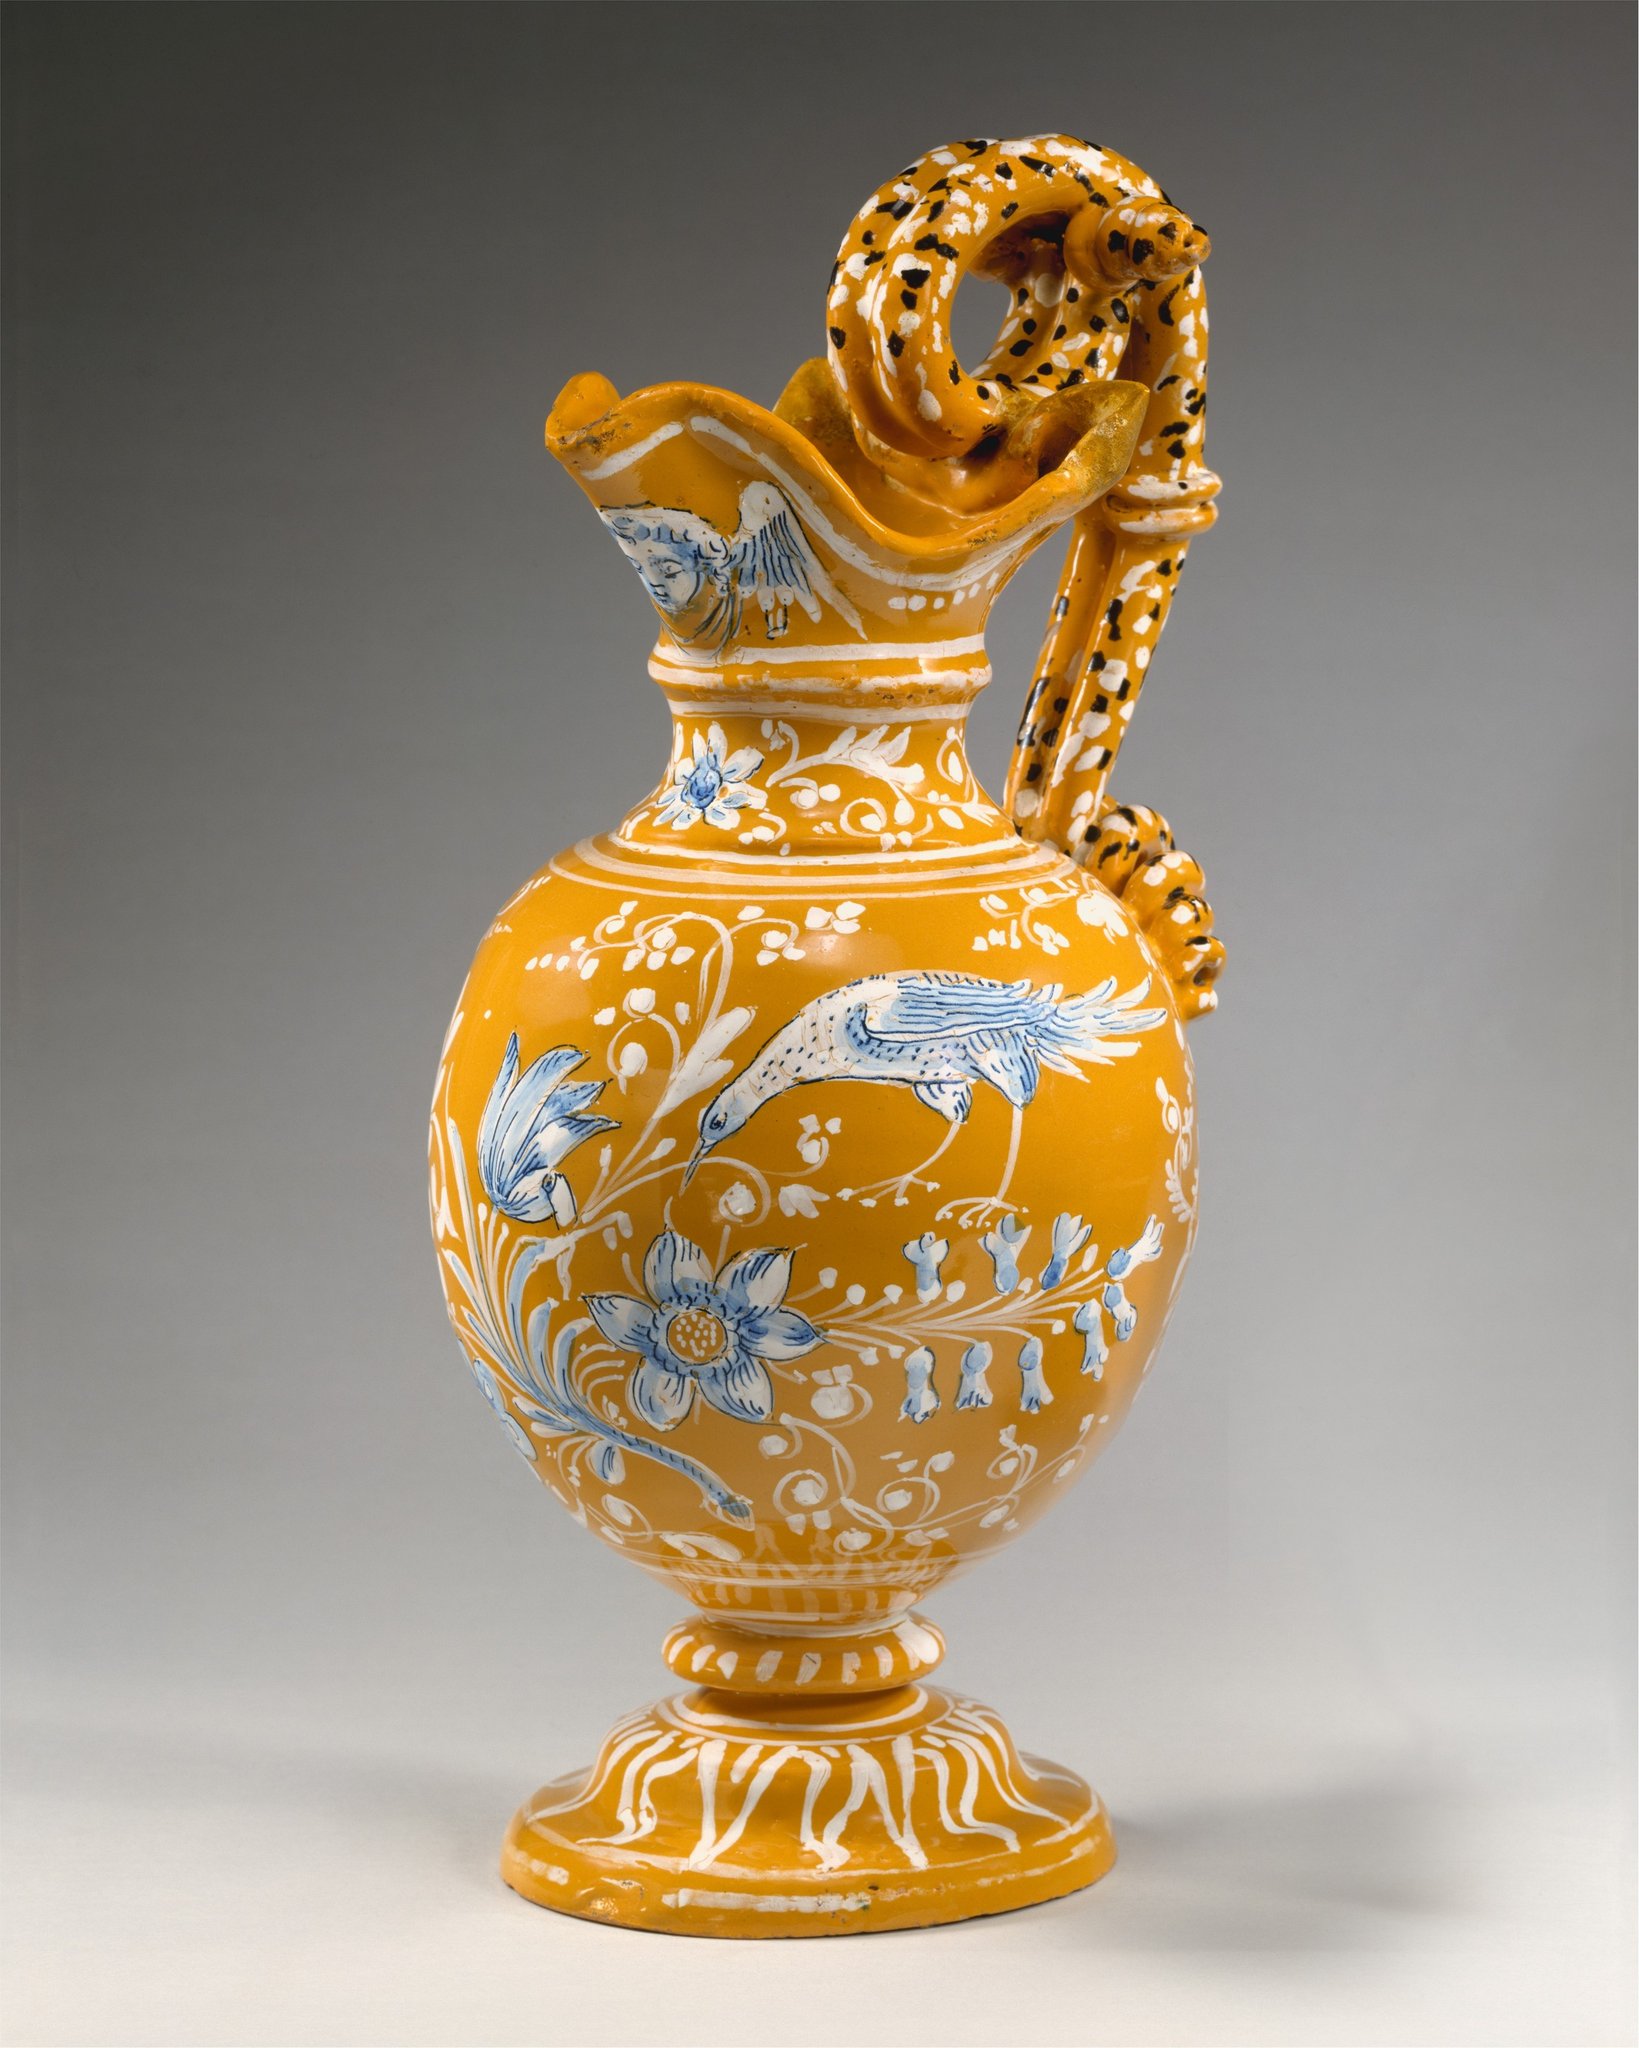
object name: ewer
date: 1650-1680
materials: faience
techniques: glazing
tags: birds,flowers